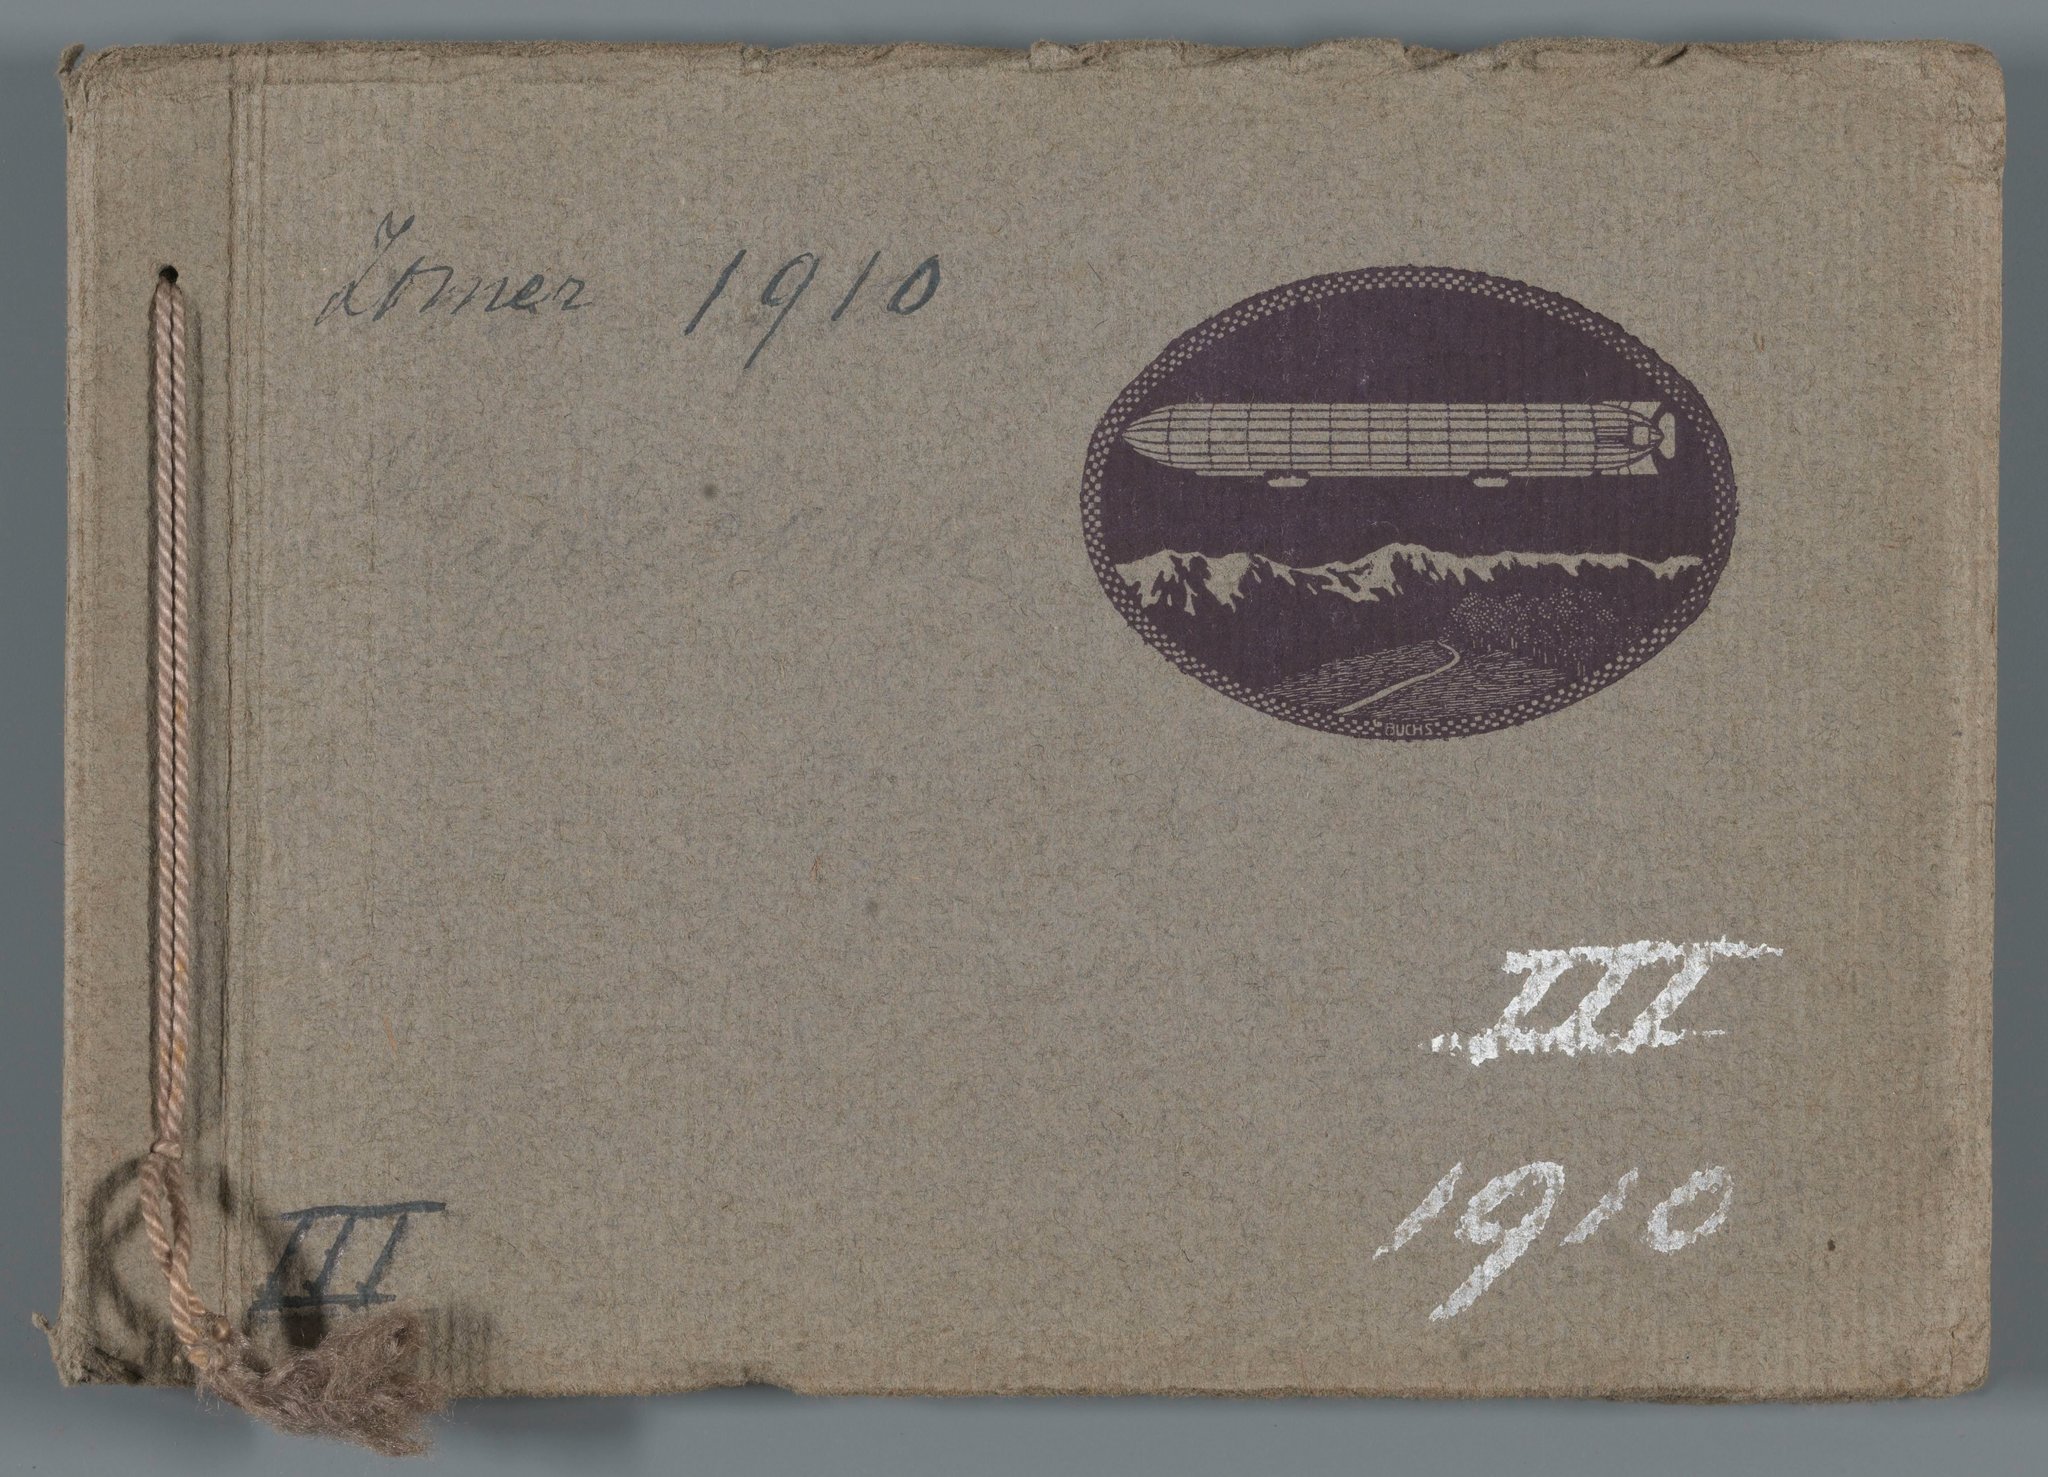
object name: scrapbook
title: Fotoalbum van familie Van den Berg, 1910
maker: hendrik herman van den berg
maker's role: amateurfotograaf, jurist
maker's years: 1875-1944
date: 1910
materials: paper, cardboard, ink, fiber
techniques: gelatin silver print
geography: netherlands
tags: caroline louise van den berg-van den berg, carel frederik van den berg (cay), mother and son(s) (family group), toddler, the family travelling, on holiday, historical persons, forest, wood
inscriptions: inscription: ‘Zomer 1910/ III/ 1910’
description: Plakboek met 25 foto's op 24 bladen. De eerste helft van het album bevat foto's van Caroline Louise van den Berg, haar zoon Cay en twee andere vrouwen op landgoed Heydebosch. De tweede helft van het album bevat foto's van Cay van den Berg. De fotograaf en samensteller is waarschijnlijk Hendrik Herman van den Berg.